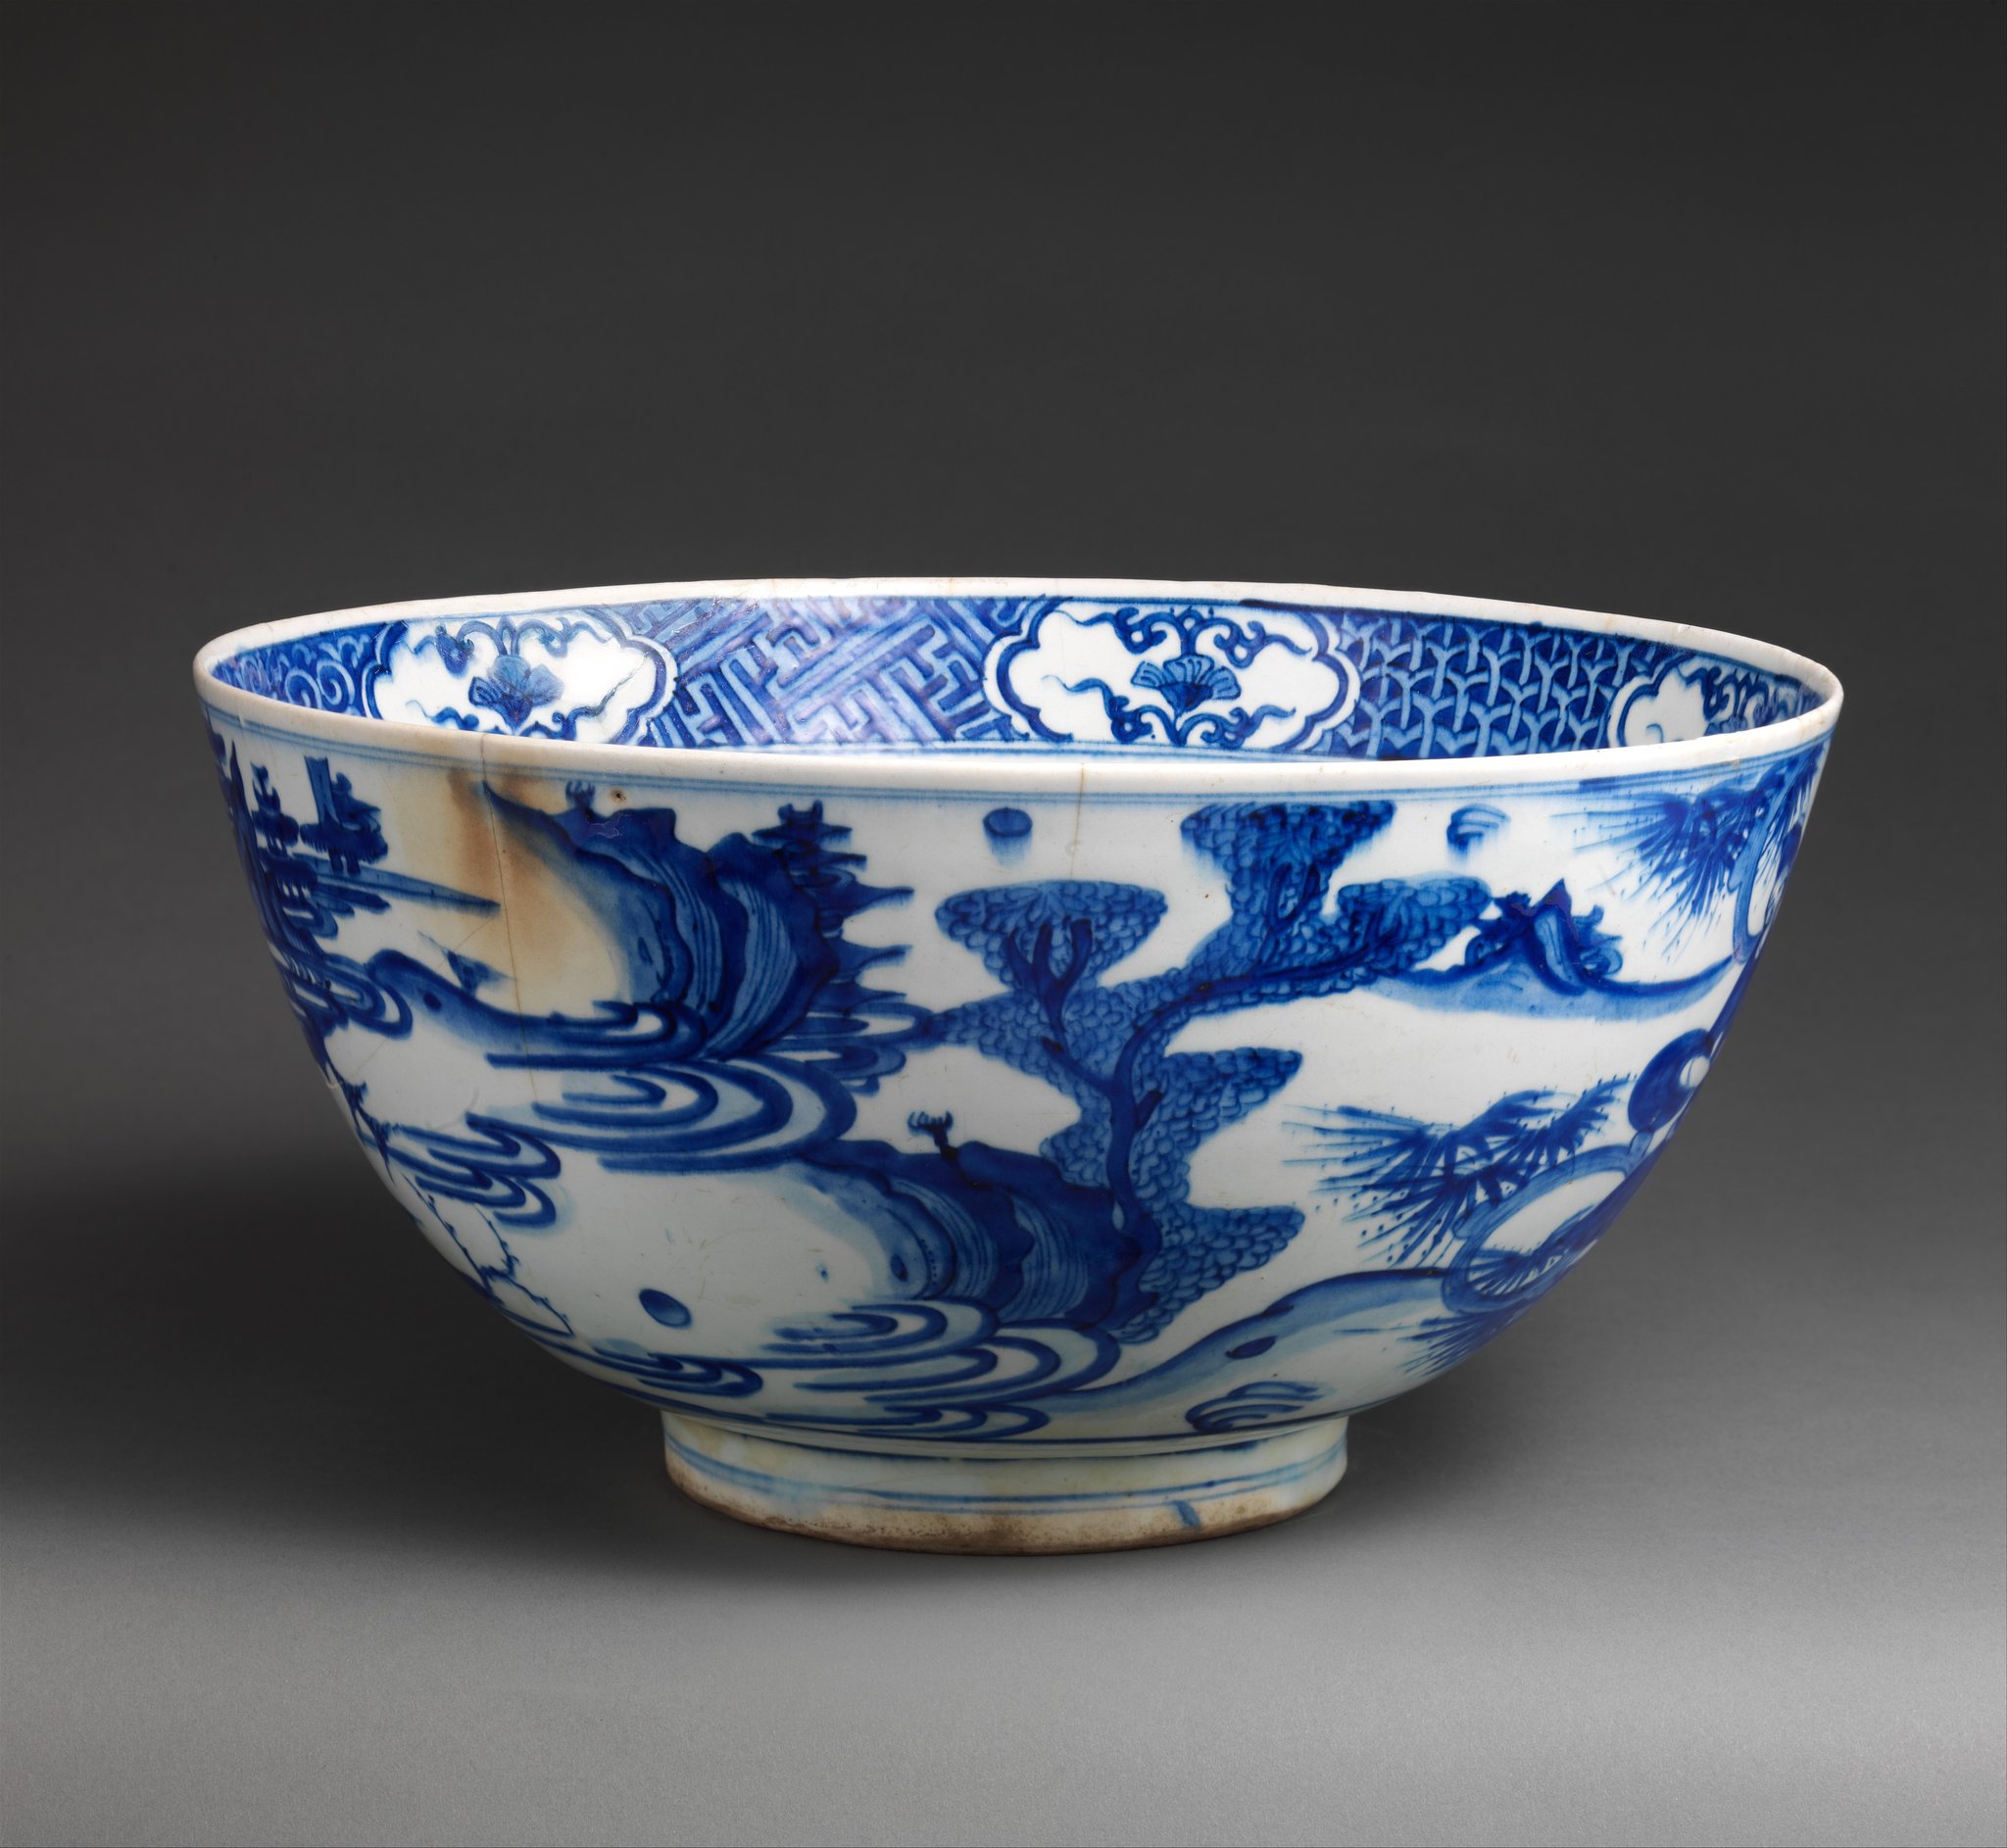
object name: dish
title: Imitation Blue-and-White Bowl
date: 1601-1700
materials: glaze, stonepaste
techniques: painting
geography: iran